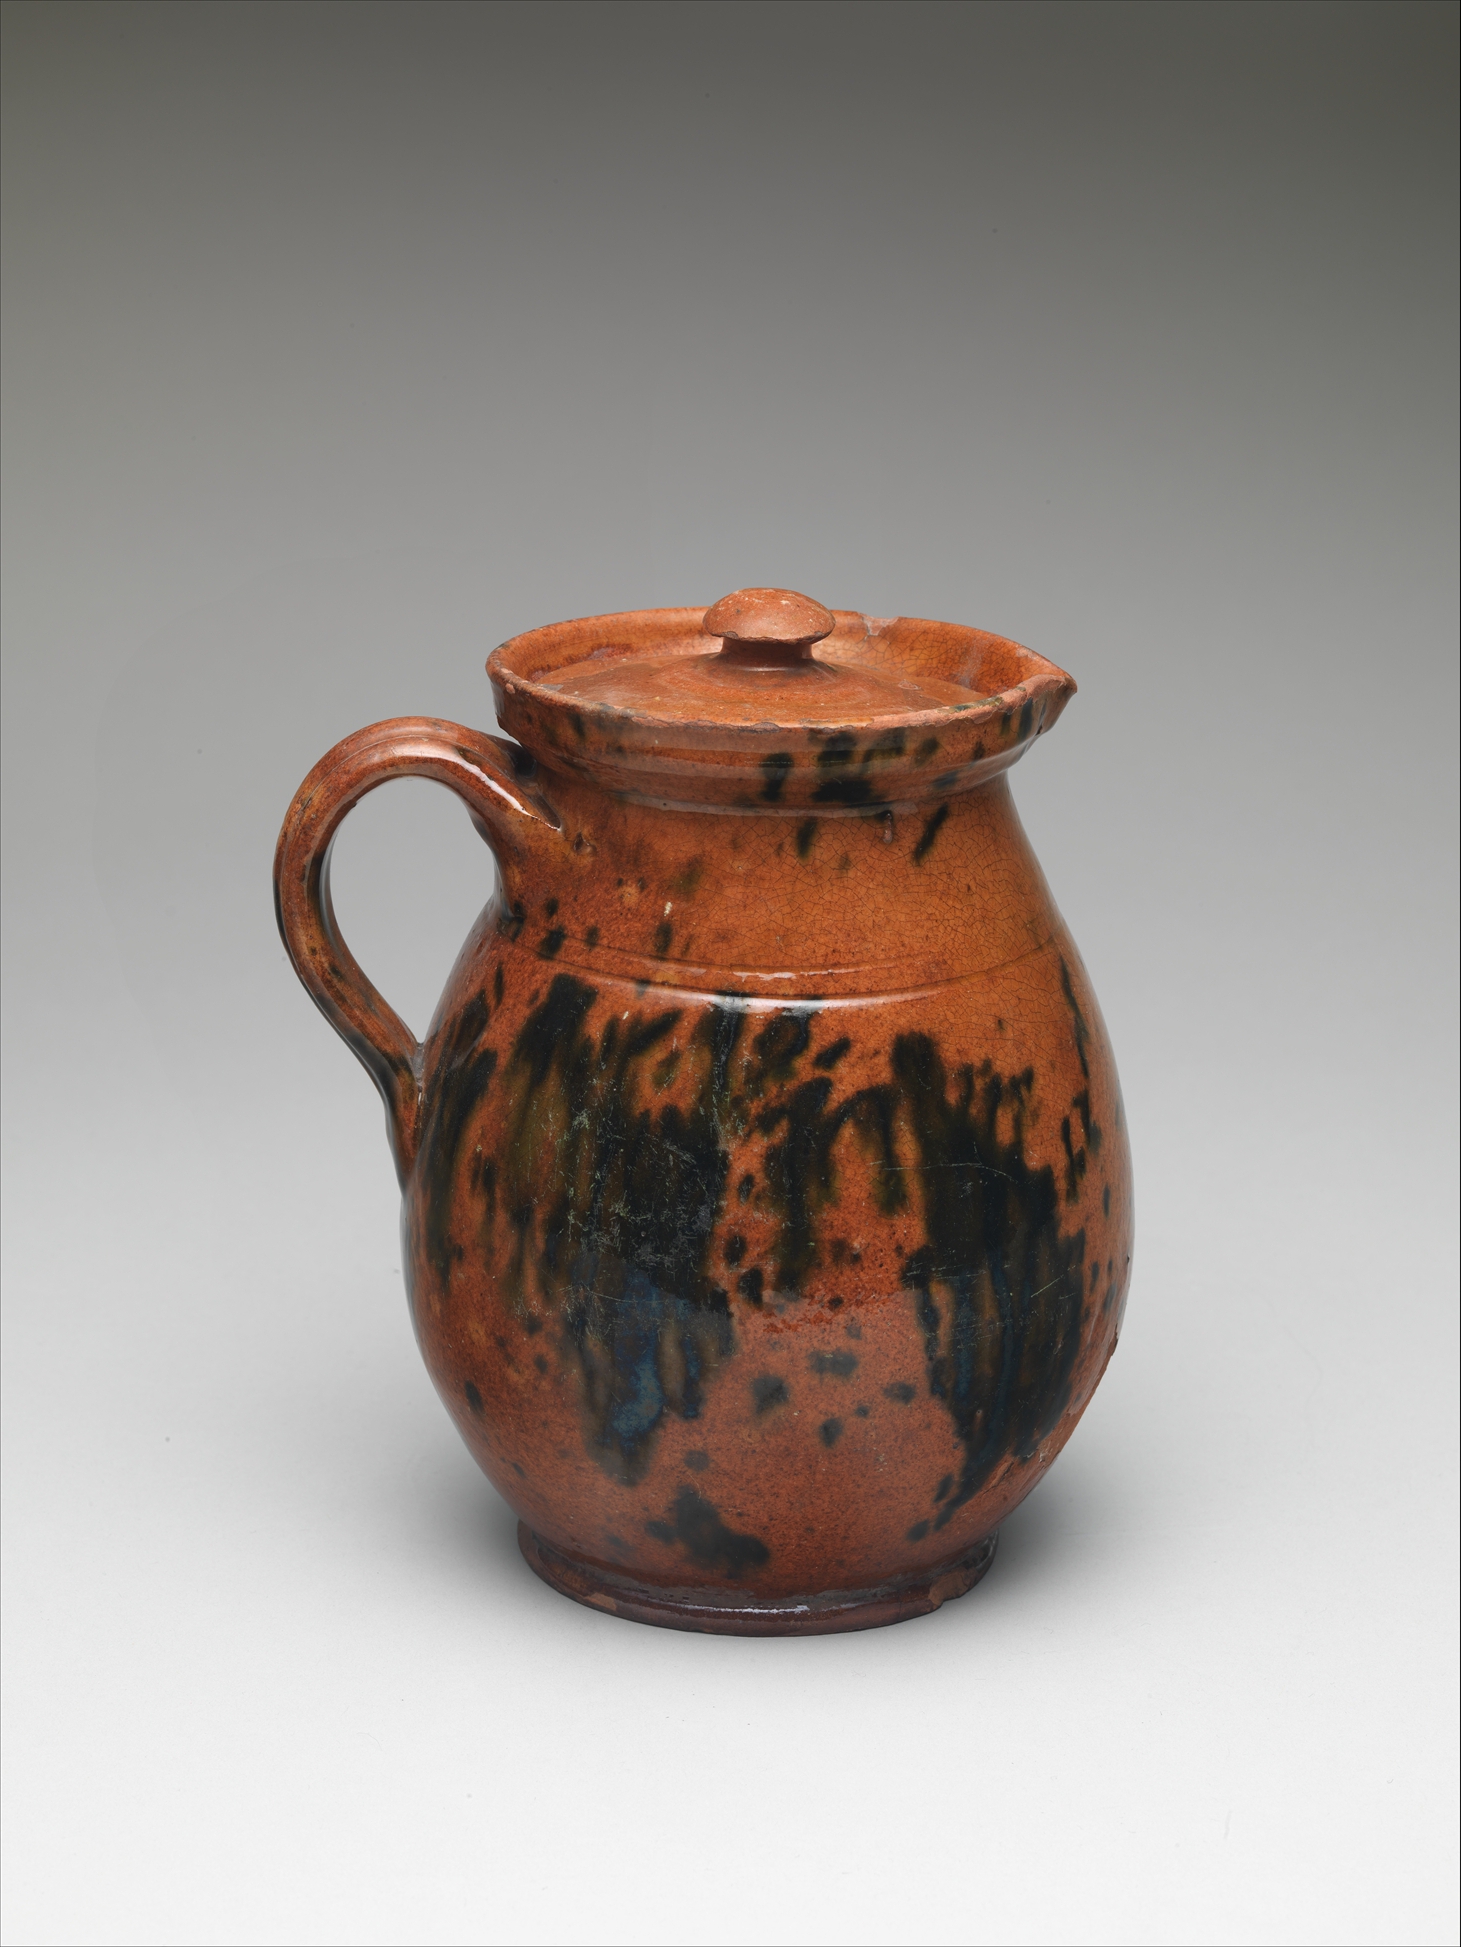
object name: pitcher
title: Covered Pitcher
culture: american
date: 1700-1900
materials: earthenware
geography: united states